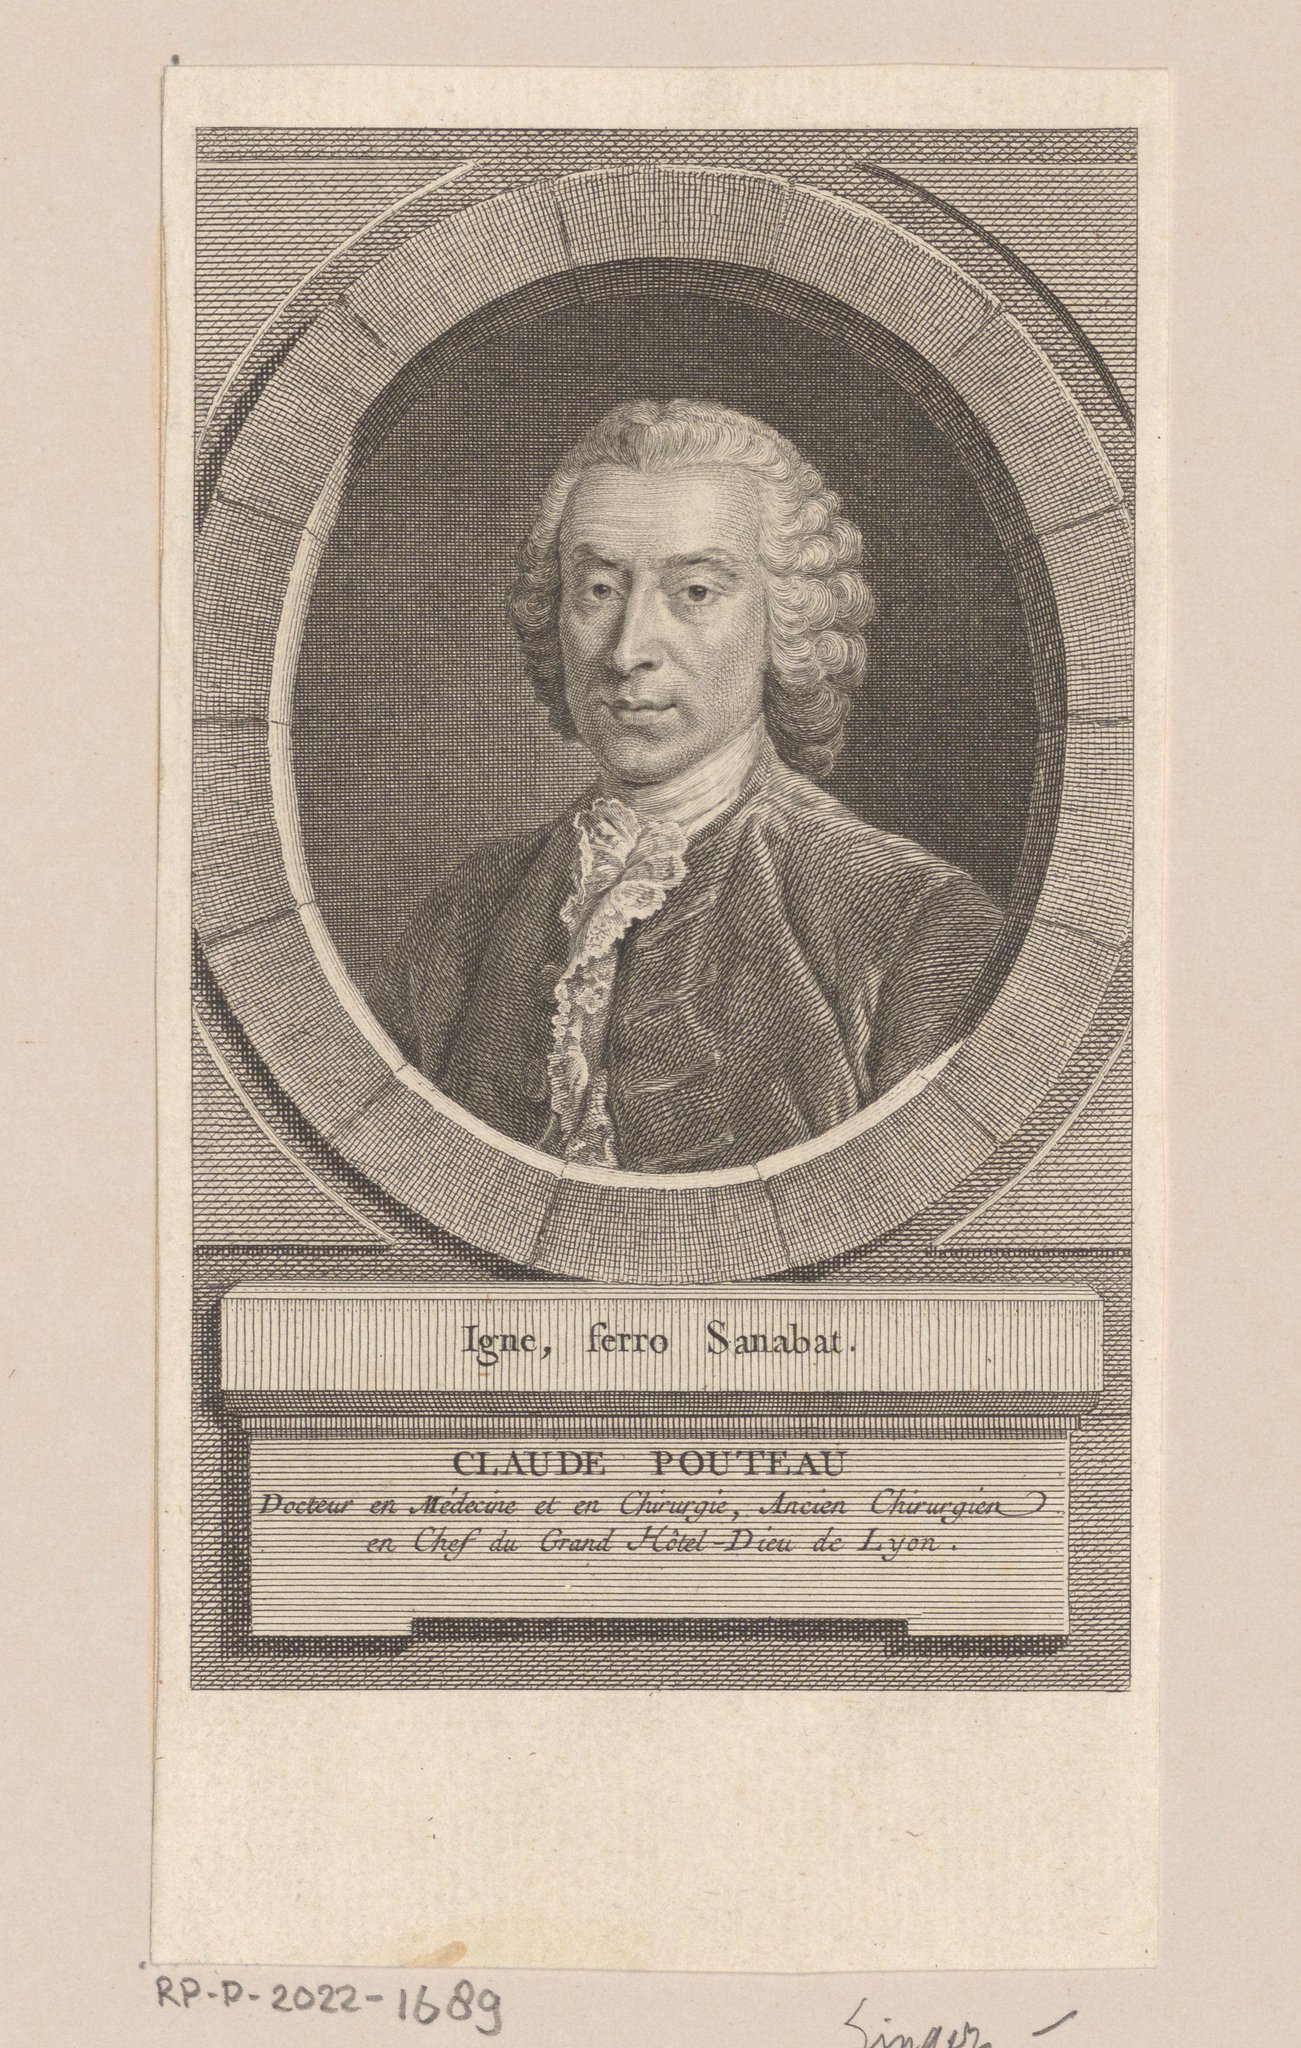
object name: print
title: Portret van Claude Pouteau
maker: Anonymous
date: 1783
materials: paper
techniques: engraving, etching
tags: lyon, historical persons, barber; surgeon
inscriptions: inscription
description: Prent waarschijnlijk uit: Pouteau, Claude. Oeuvres Posthumes. Parijs: Philippe-Denis Pierres, 1783.